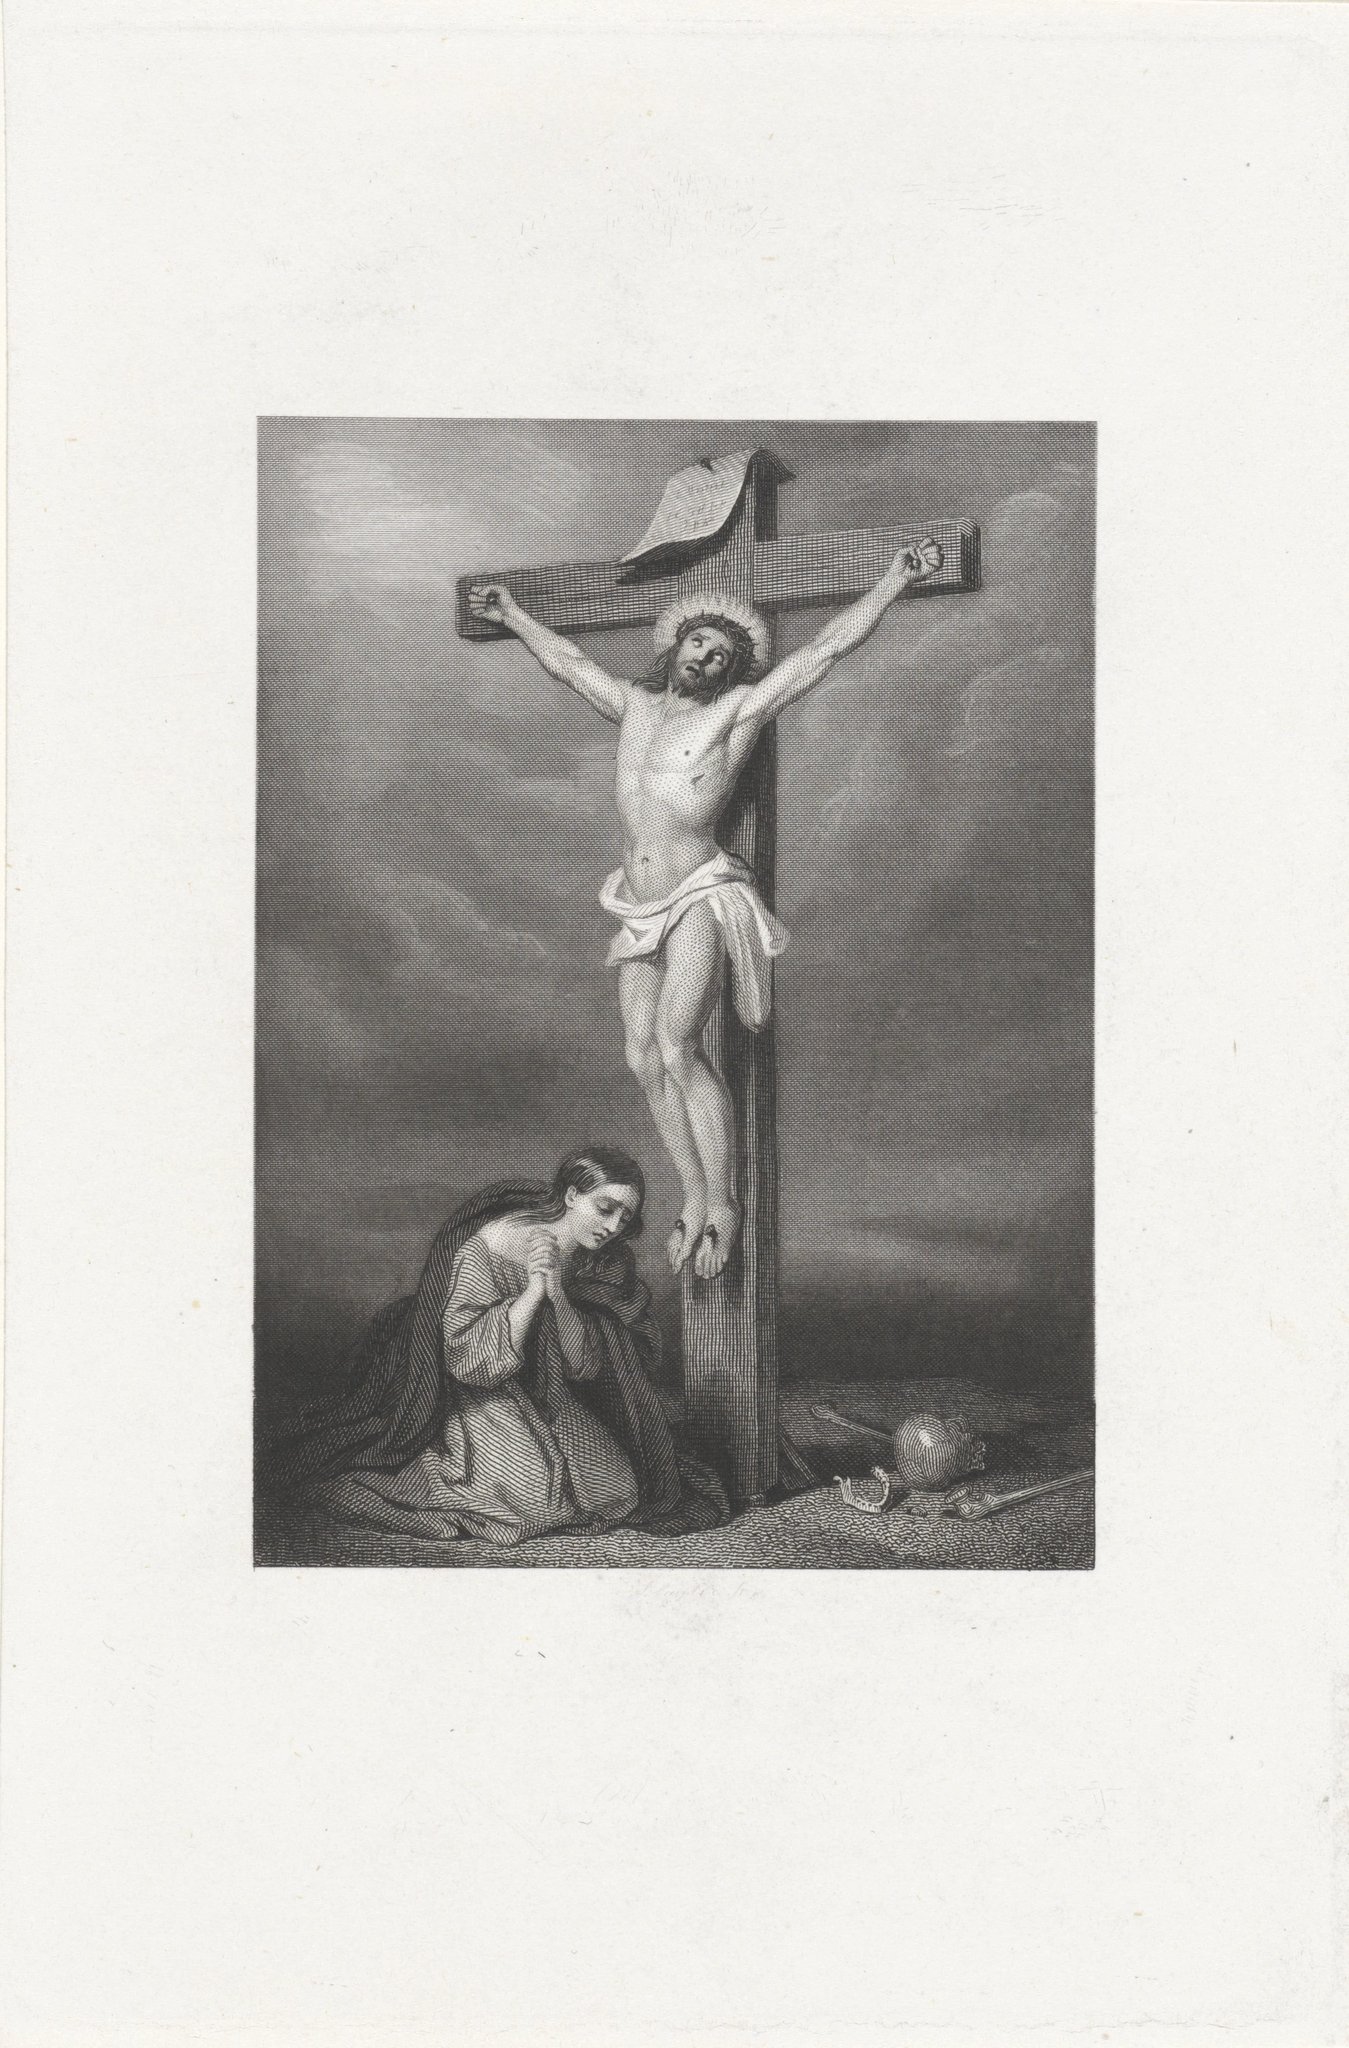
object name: print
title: Maria Magdalena bij het kruis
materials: paper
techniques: engraving, etching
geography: amsterdam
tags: crucified christ with mary magdalene, who usually weeps and embraces the cross - dd - the three crosses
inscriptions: collector's mark: Lugt 2228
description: Maria Magdalena knielt bij het kruis met Christus. op de grond liggen een schedel met knekels.